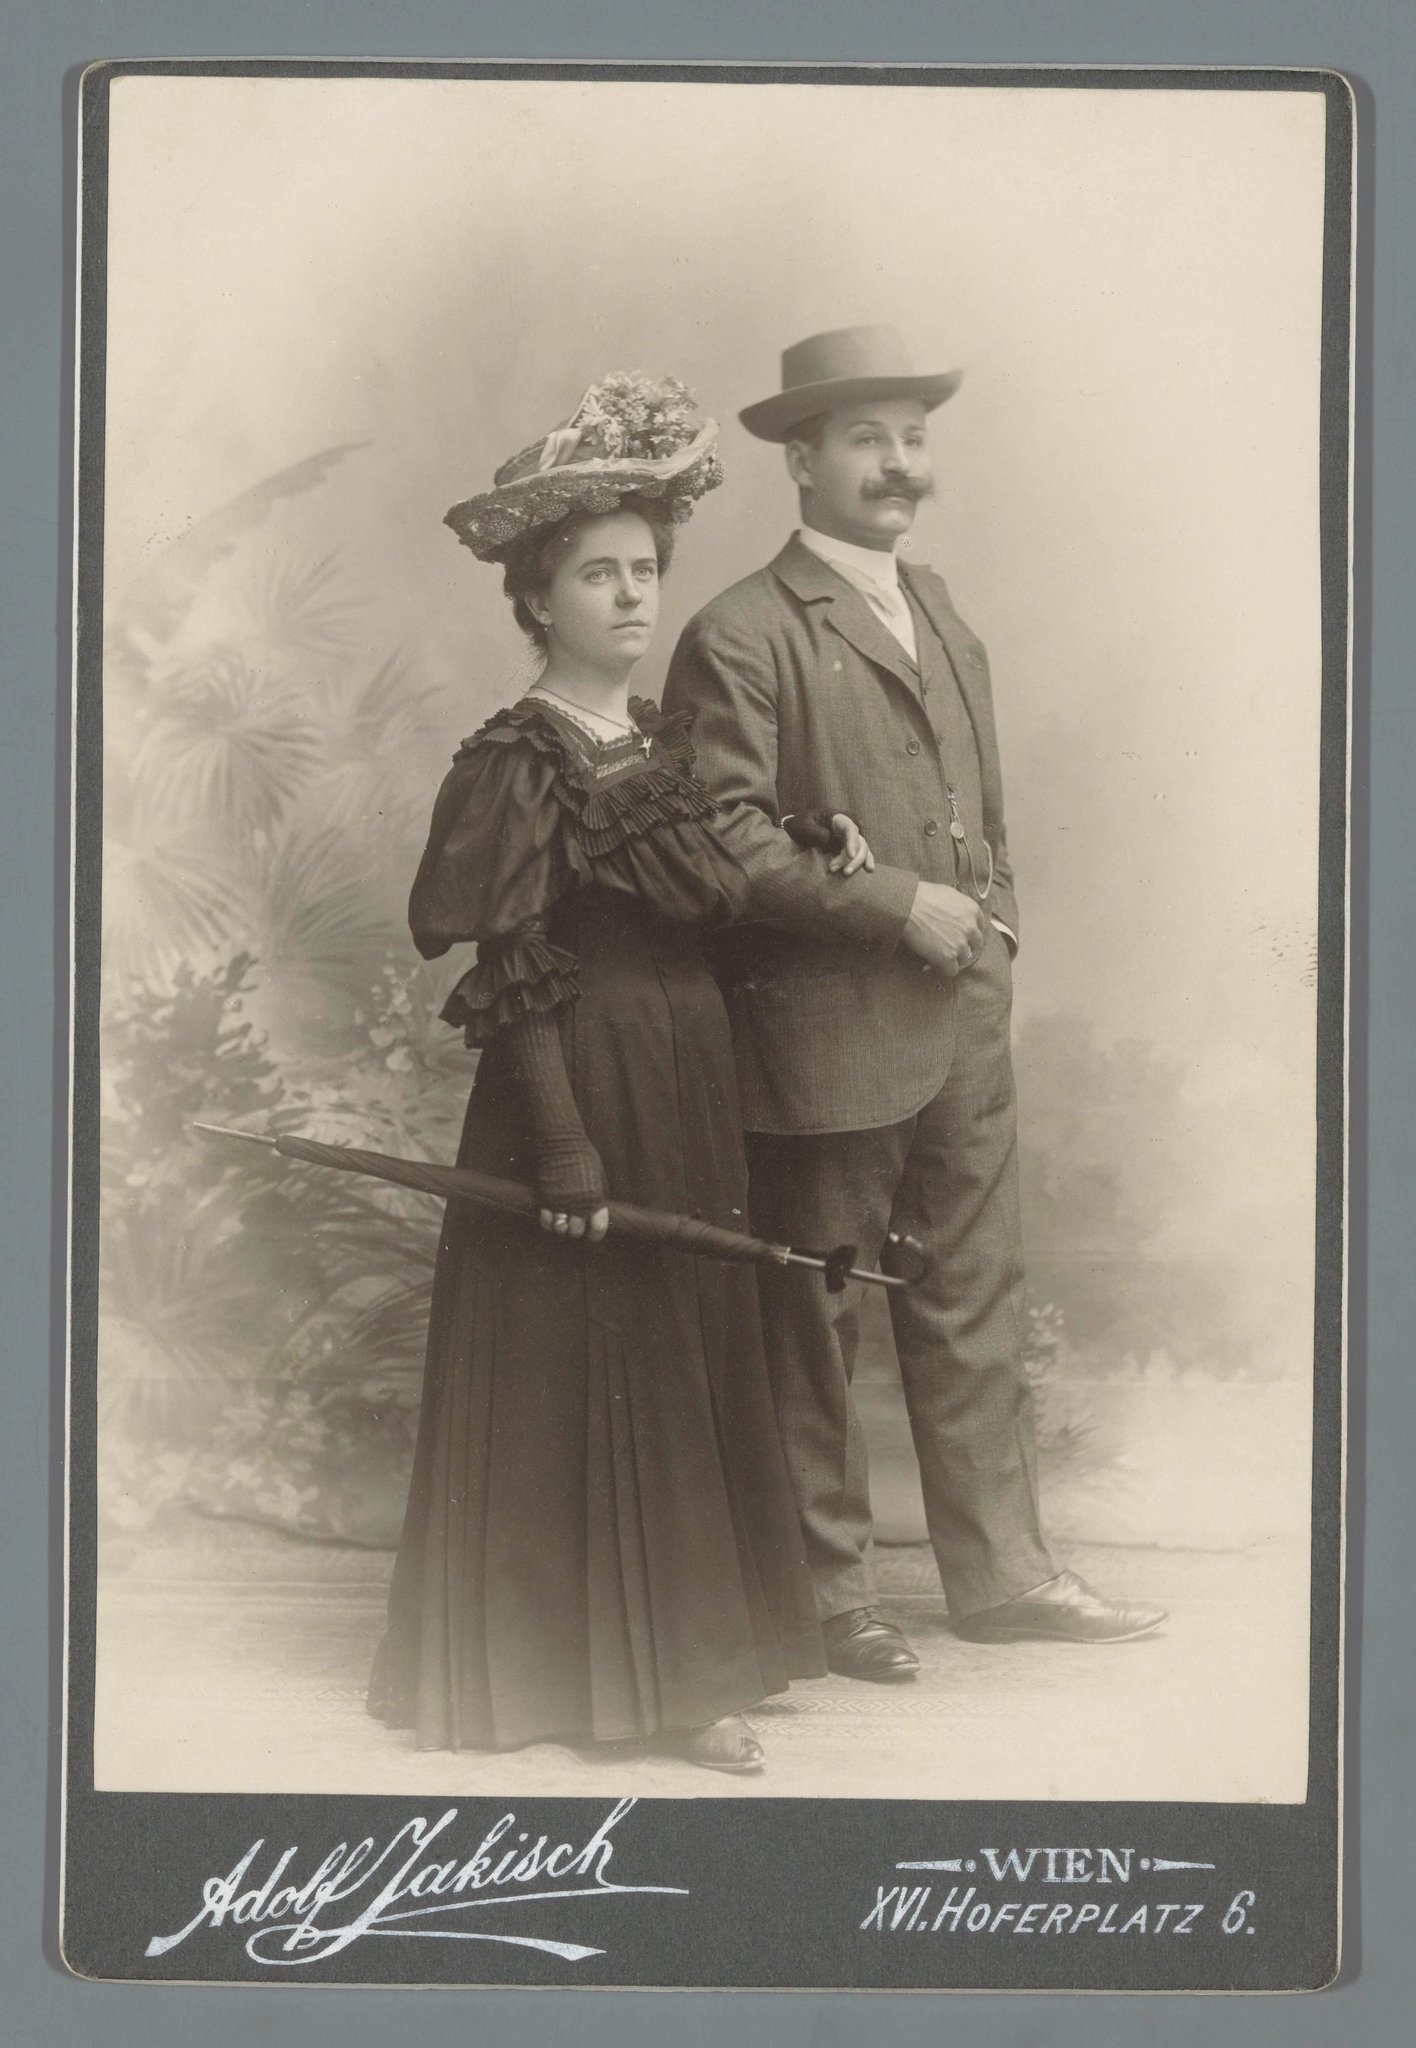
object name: cabinet photograph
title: Portret van een onbekende man en vrouw arm in arm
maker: adolf jakisch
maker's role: fotograaf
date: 1880-1906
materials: cardboard, photographic support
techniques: matte daylight collodion silver print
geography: vienna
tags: adult woman, adult man, umbrella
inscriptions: name: ‘Adolf Jakisch Fotograf Wien XVI Hoferplatz 6.’, inscription: ‘Zu Erinn[...]ng [...] Wien den 7. uli 1906’